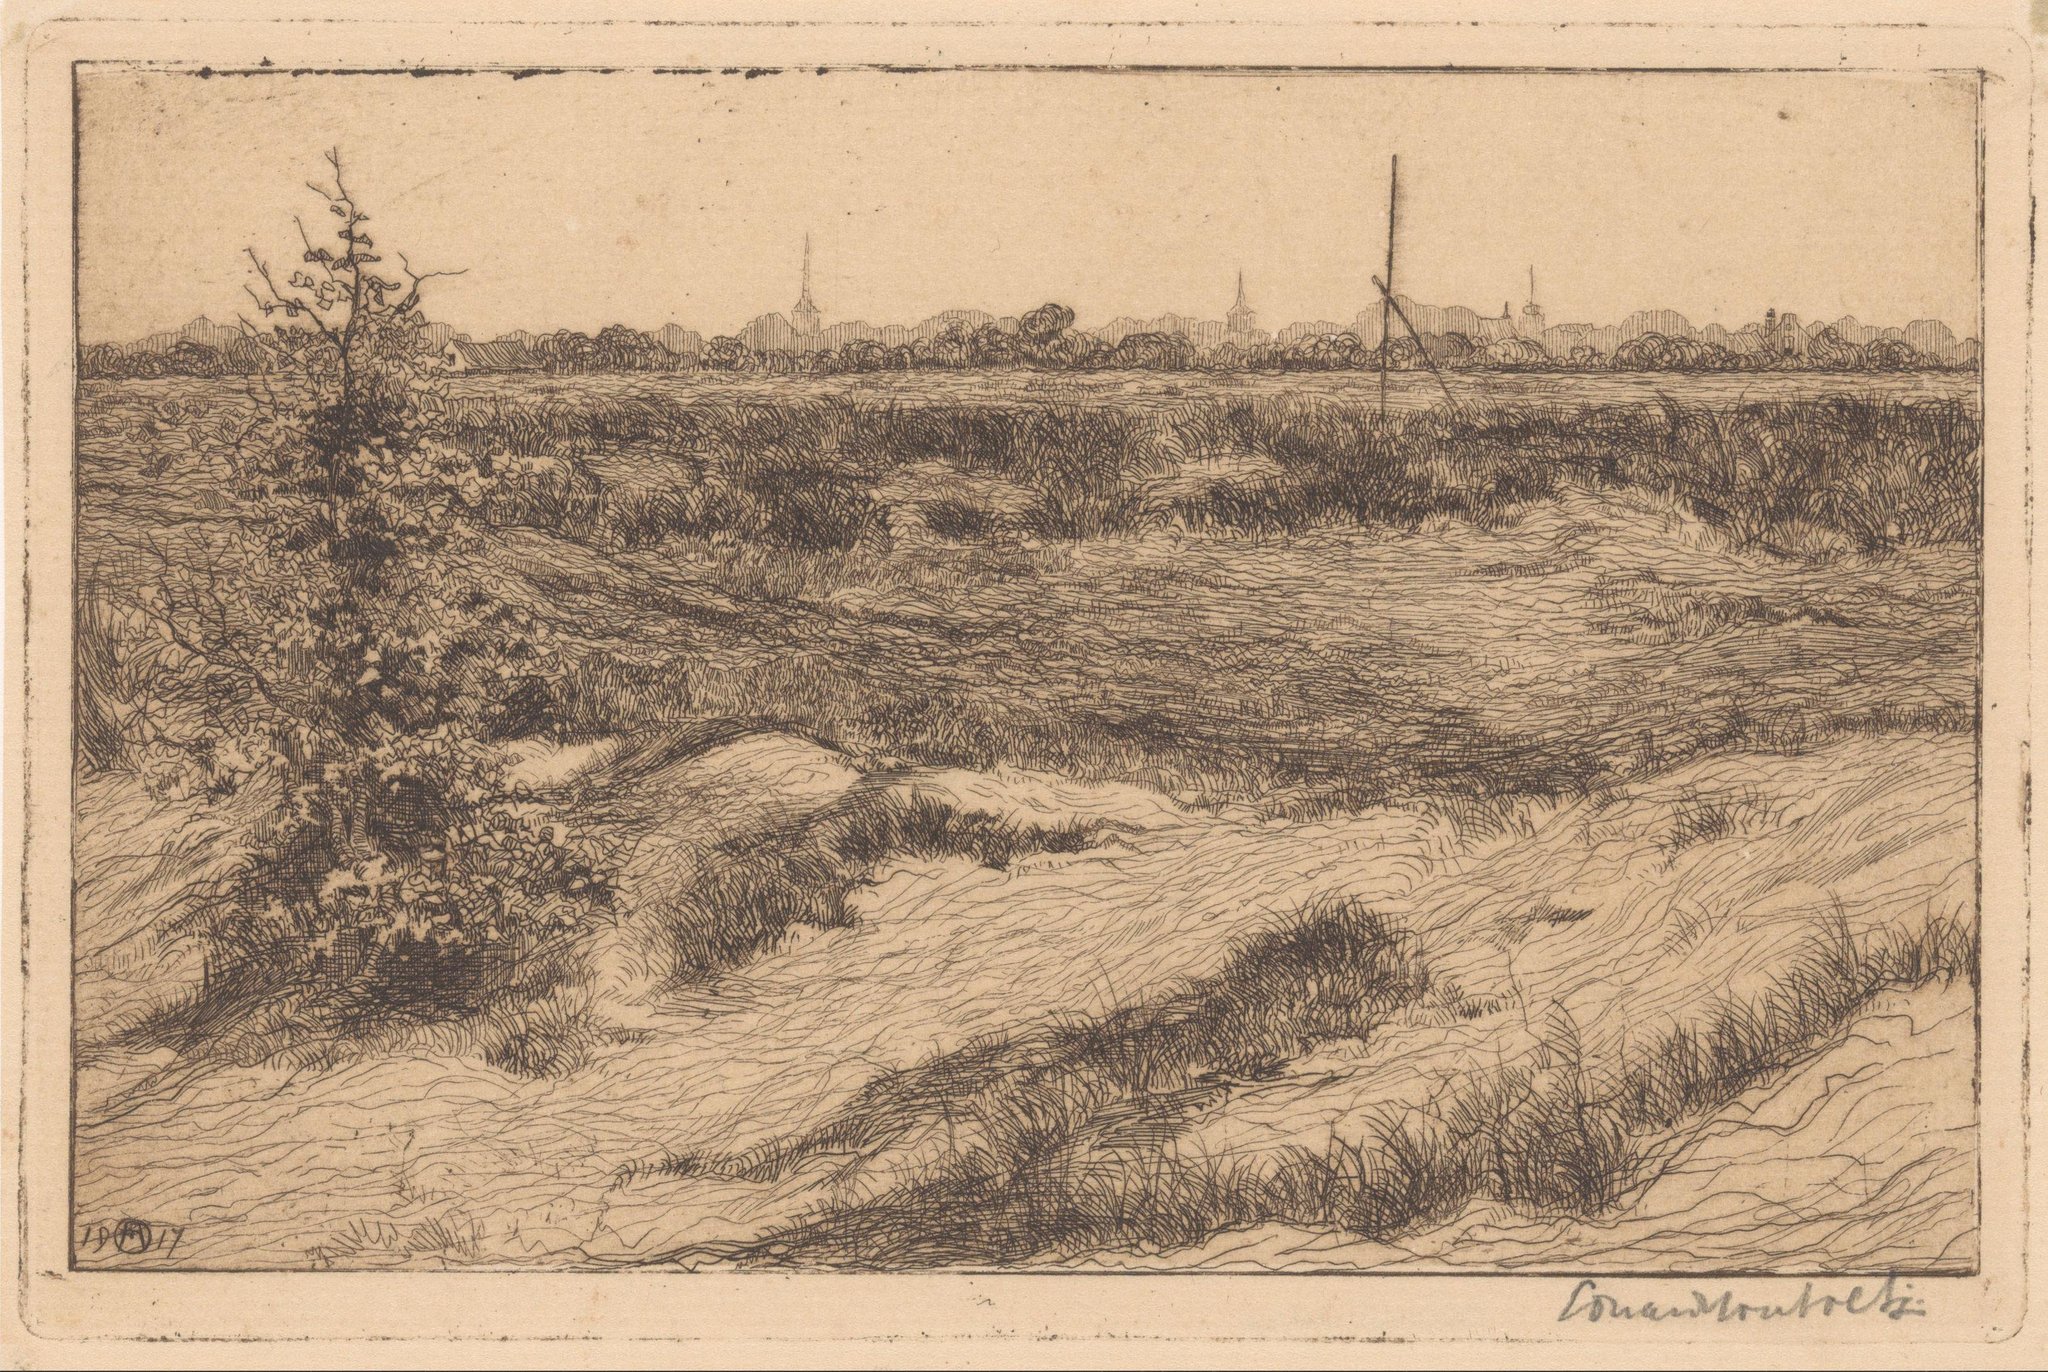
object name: print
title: Heidelandschap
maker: eduard houbolt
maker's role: print maker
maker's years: 1885-1954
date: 1917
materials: paper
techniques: etching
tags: prospect of village, silhouette of village, meadow, pasture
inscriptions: collector's mark: Lugt 2228, collector's mark: Lugt 2760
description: Heide met aan de horizon een dorp. Links een struik.